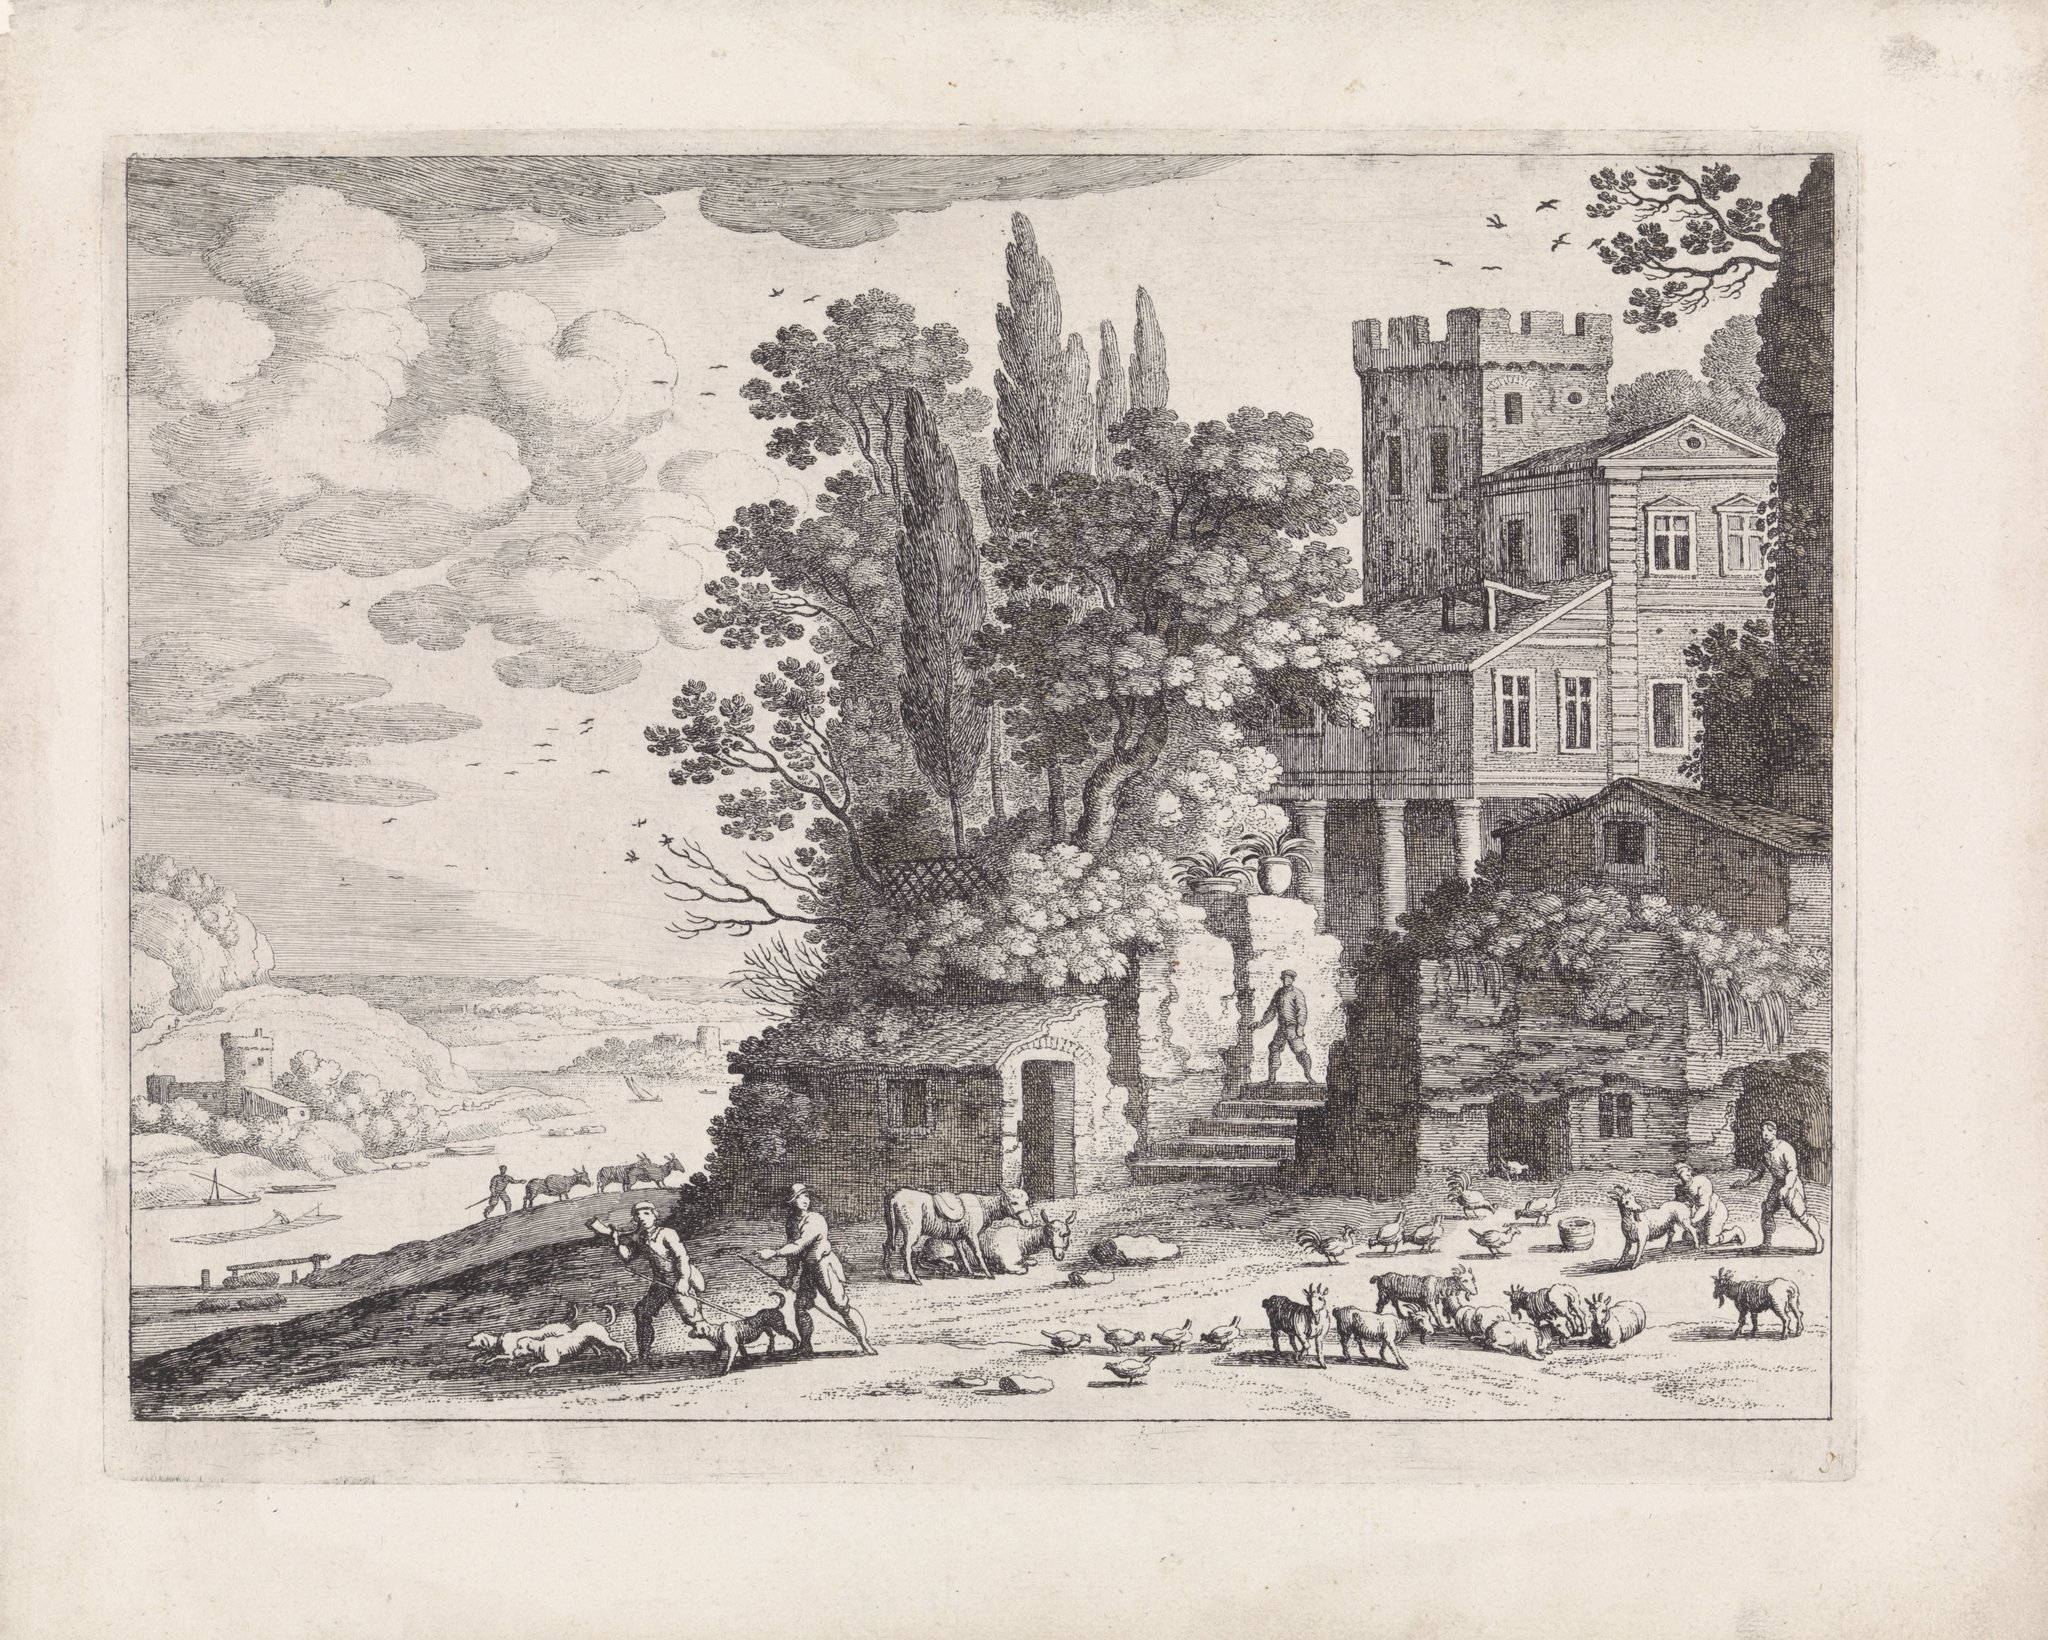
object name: print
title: Landschap met een huis, figuren en vee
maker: guilliam van nieulandt (ii)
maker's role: draughtsman, print maker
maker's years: 1584-1635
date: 1594-1635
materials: paper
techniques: brush, engraving, etching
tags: cattle, landscapes in the temperate zone, hunting horn, villa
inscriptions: collector's mark: Lugt 2760, inscription: ‘8’, collector's mark: Lugt 2228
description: Een Italiaans landschap met een huis met toren. Op de voorgrond geiten, kippen, ezels en twee mannen met jachthoorn en jachthonden. Links zicht op een rivier.